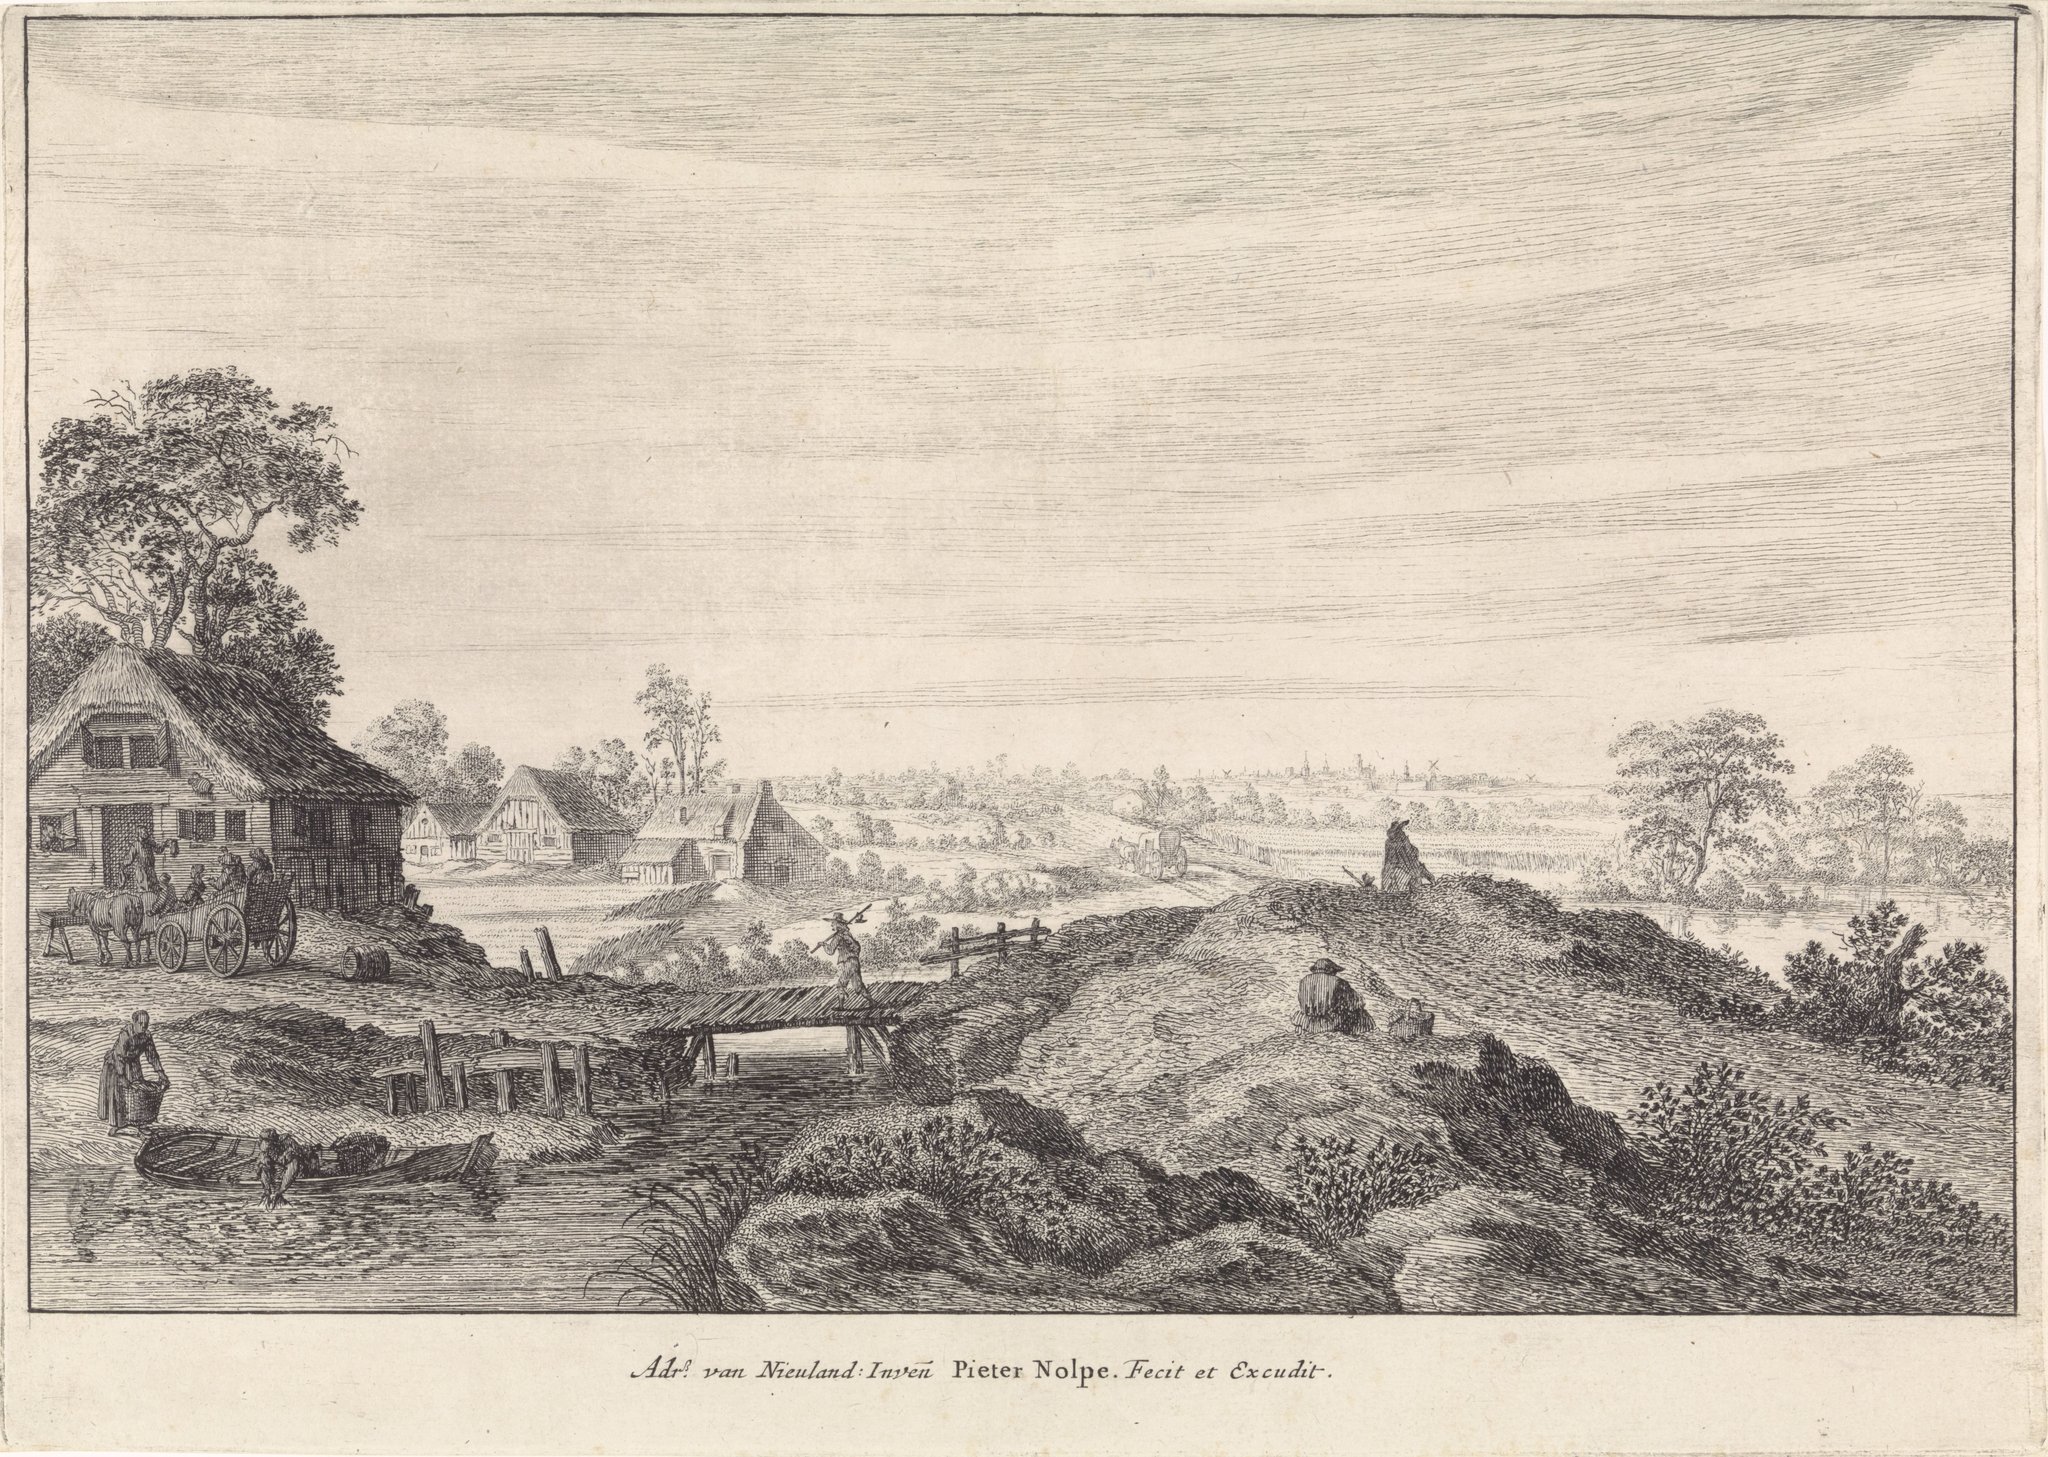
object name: print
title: Landschappen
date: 1623-1653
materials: paper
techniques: engraving, etching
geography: amsterdam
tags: four-wheeled, animal-drawn vehicle, e.g.: cab, carriage, coach, landscape with bridge, viaduct or aqueduct, farm (building), angling (+ net)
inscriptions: collector's mark: Lugt 240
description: In een landschap liggen enkele boerderijen. Bij het huis links staat een koets stil, waarvan de paarden drinken. Links trekt een man vanuit een boot een visnet uit het water. Rechts zit een man op de dijk. Prent uit een serie landschappen.